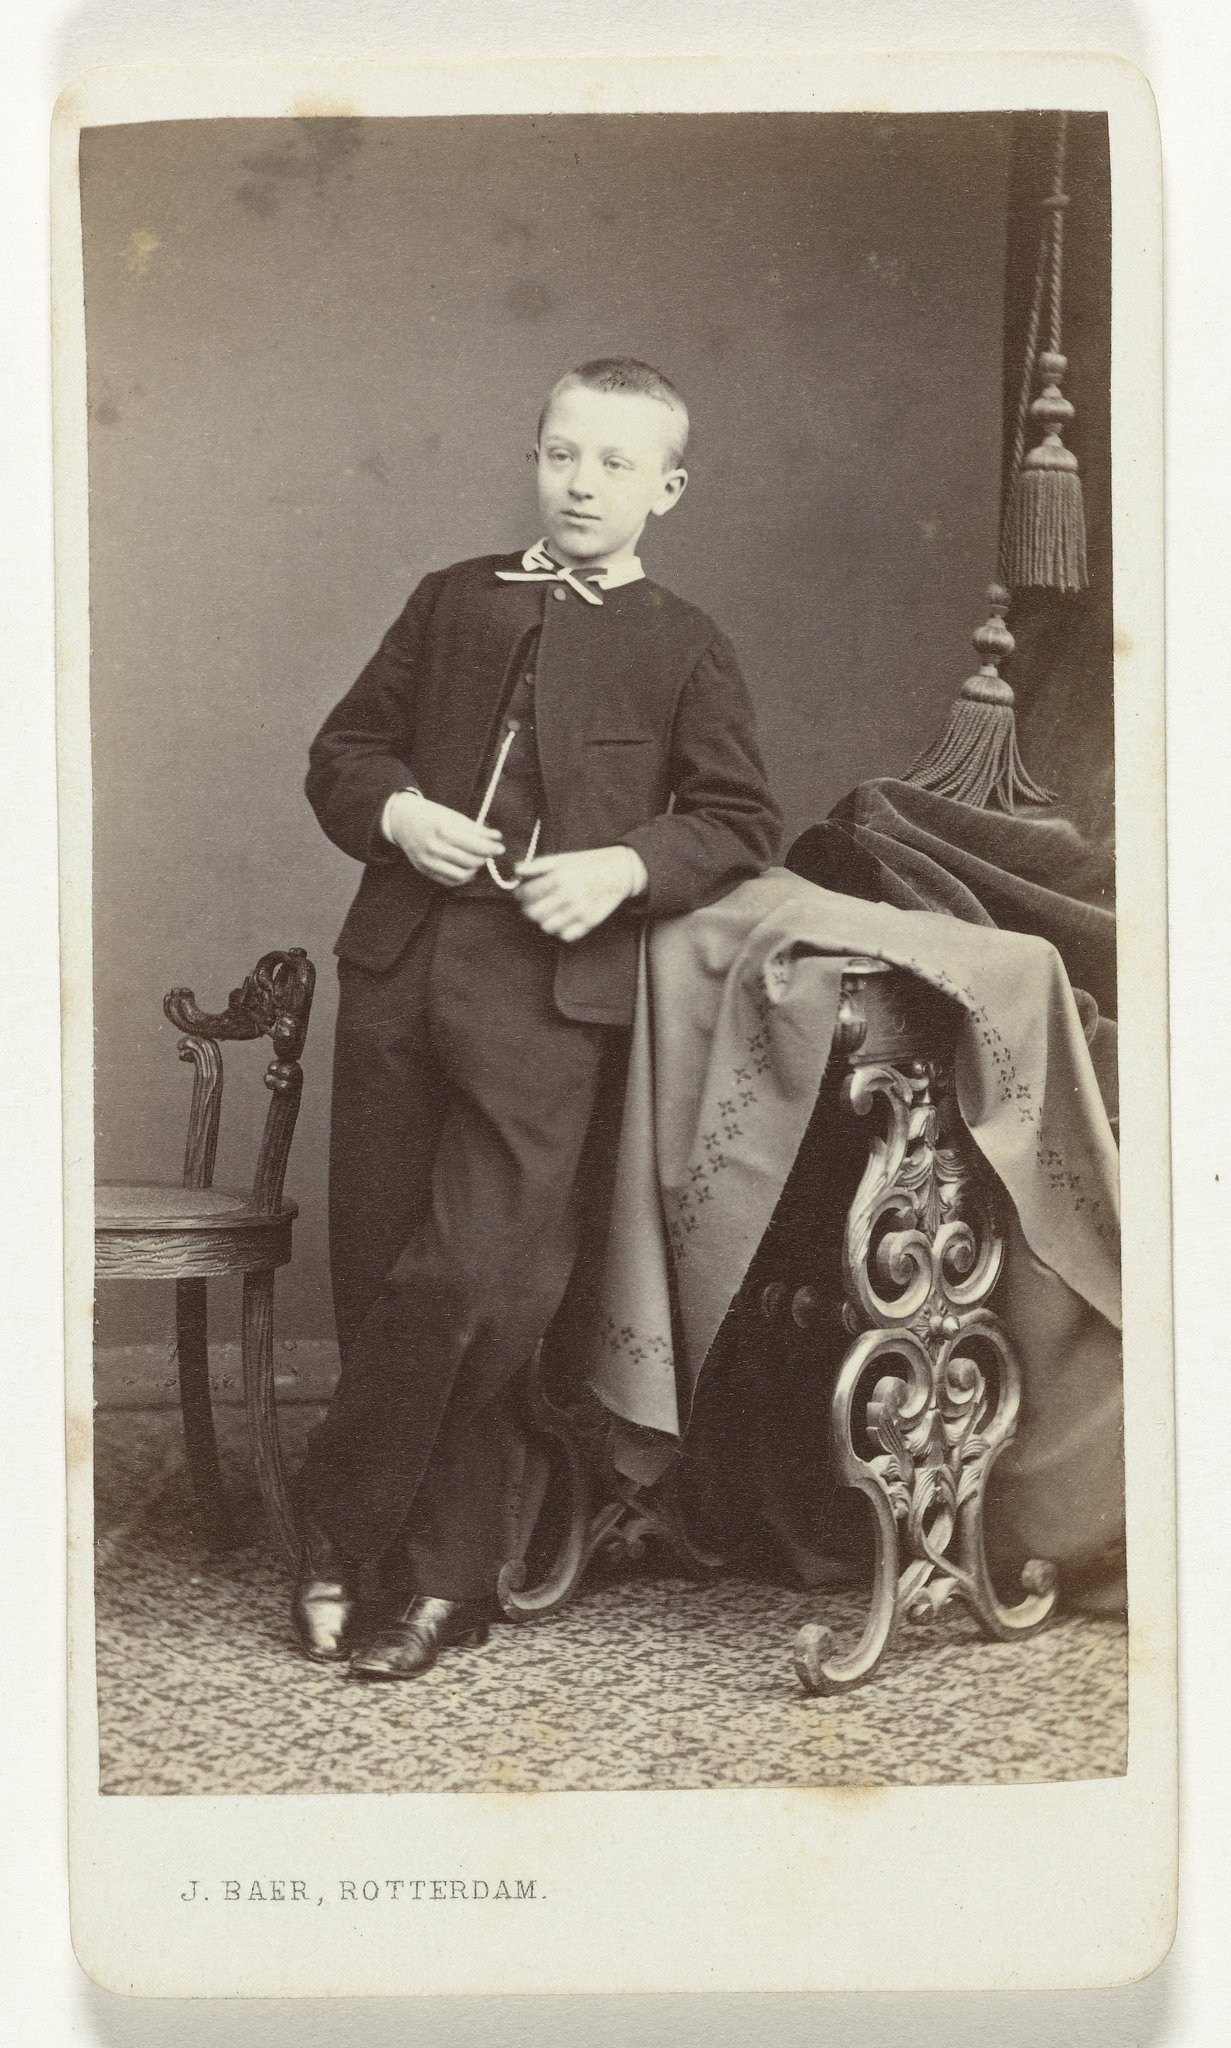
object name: carte de visite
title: Portret van een jongen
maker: johannes baer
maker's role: fotograaf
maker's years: 1840-1912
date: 1860-1865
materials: cardboard, paper, photographic support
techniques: albumen print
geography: rotterdam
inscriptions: address: ‘J. Baer/Photographe/Rotterdam’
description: Een jongen staat geleund tegen een met een doek bedekt tafeltje. Rechts een gordijn met grote kwasten.